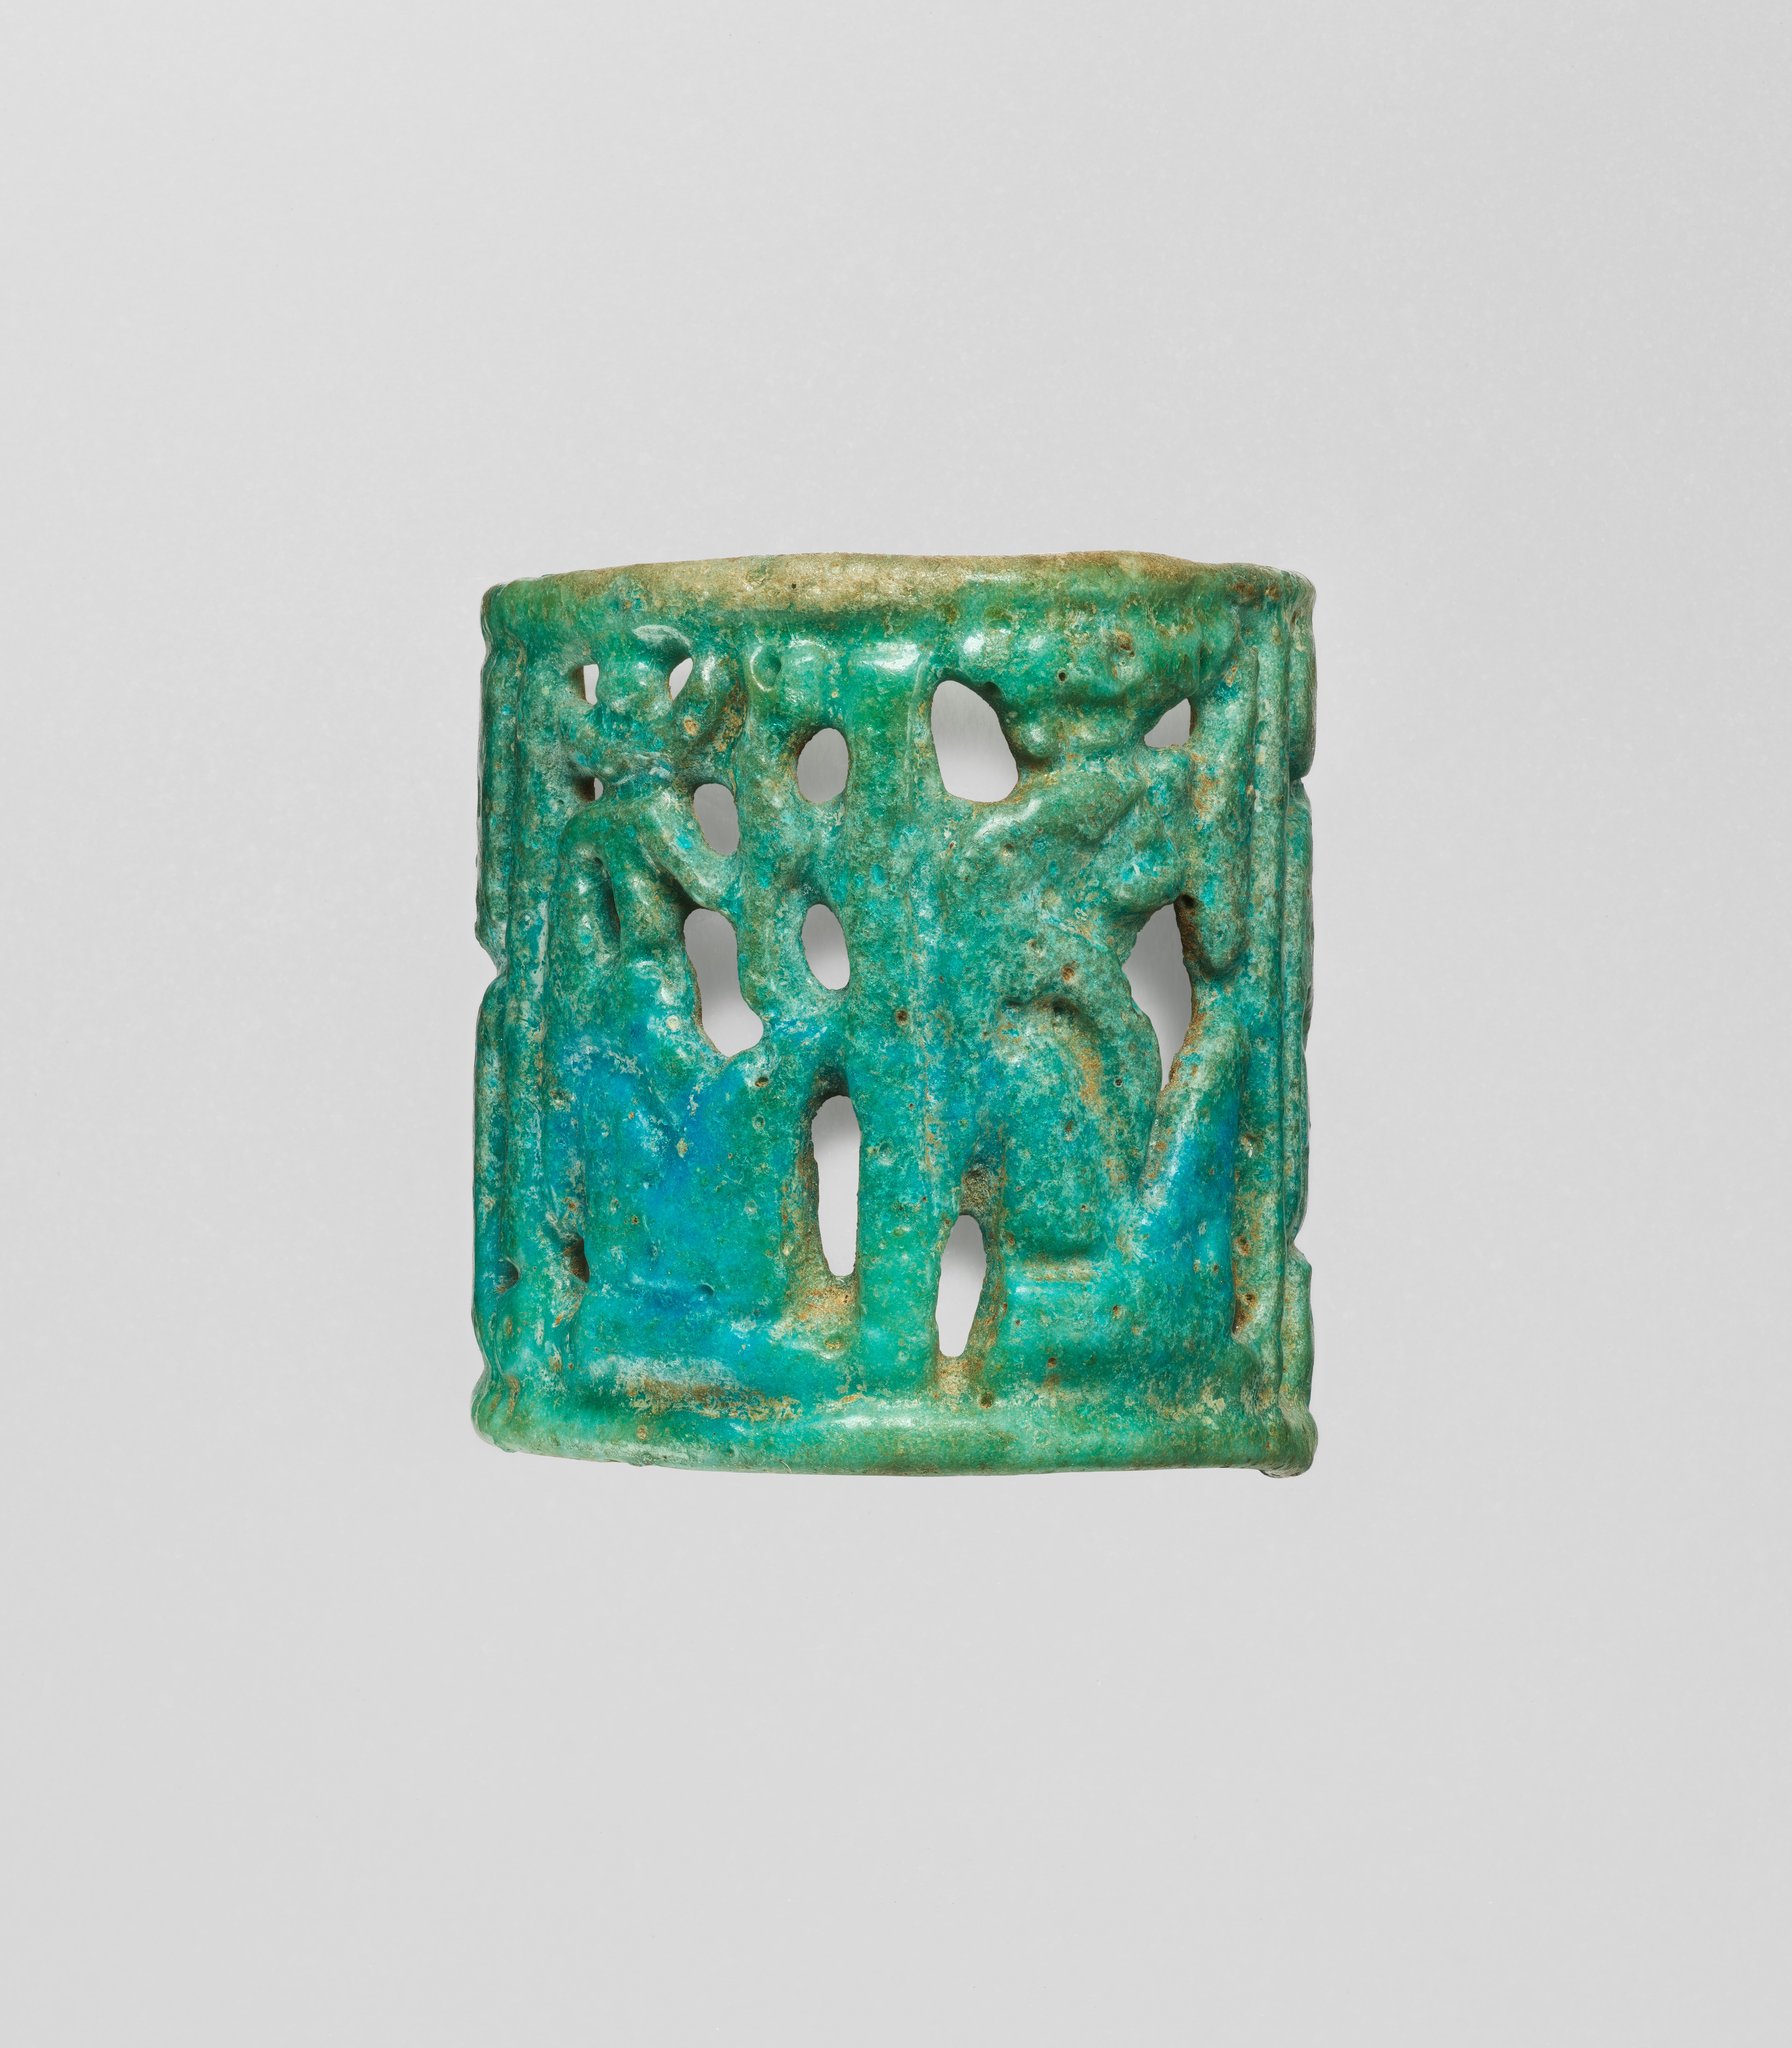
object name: ring, openwork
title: Openwork Ring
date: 1070-712 BCE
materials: faience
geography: egypt